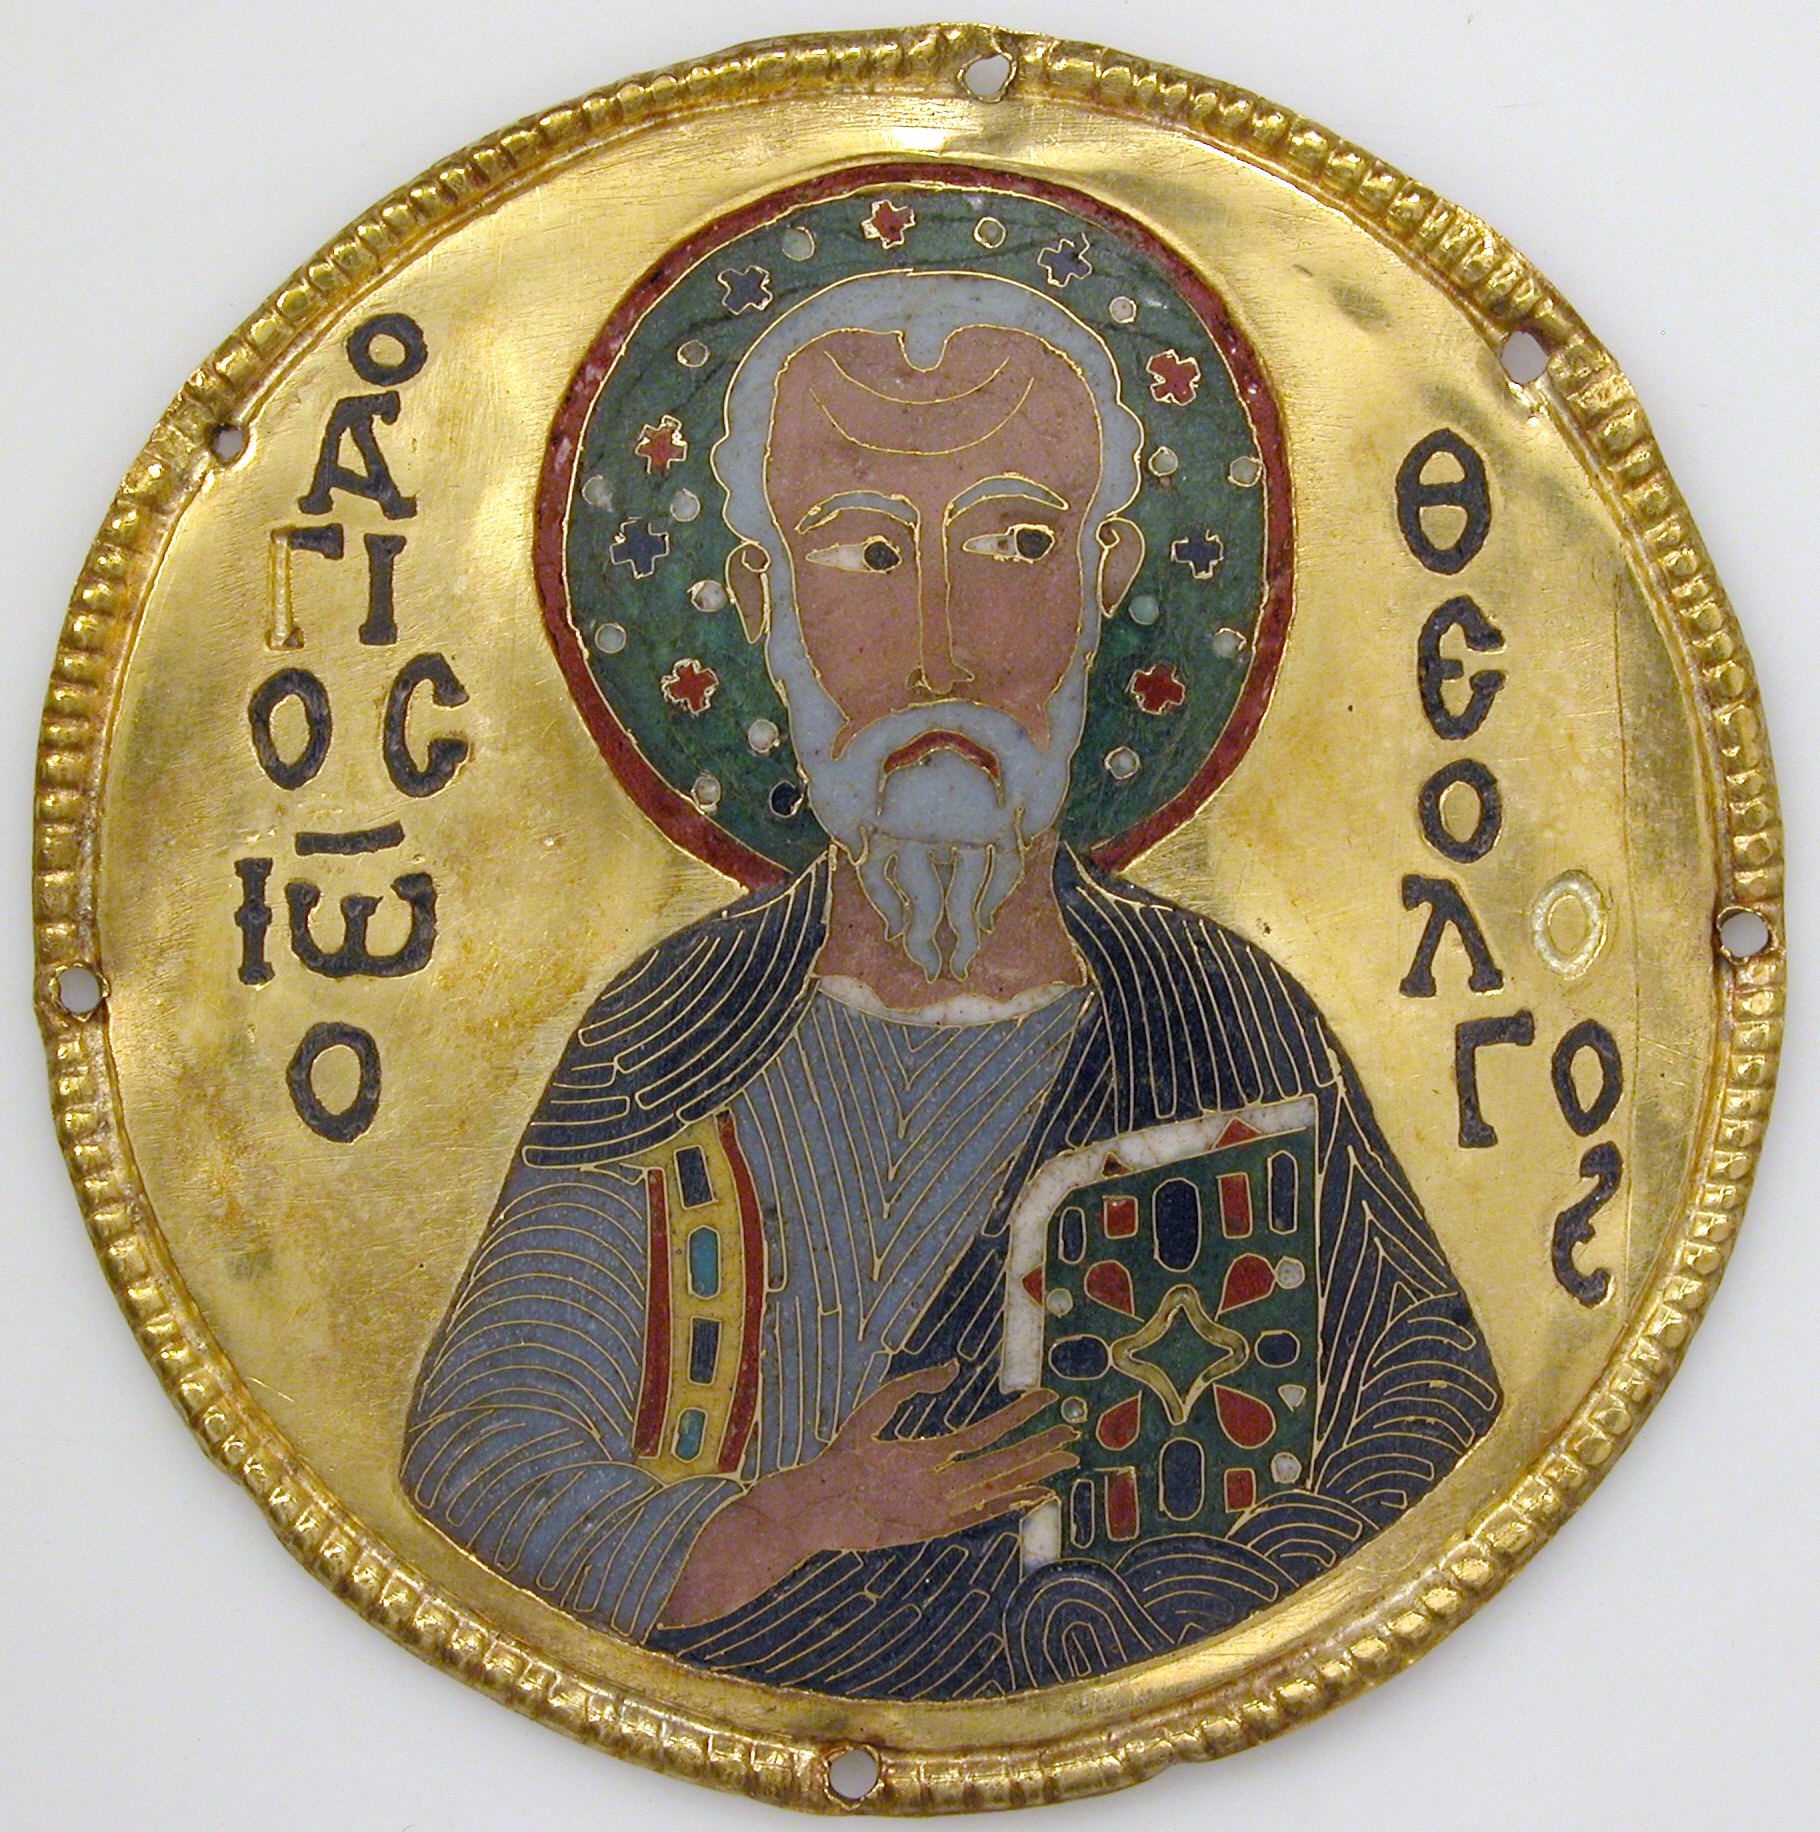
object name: medallion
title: Medallion with Saint John the Evangelist from an Icon Frame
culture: byzantine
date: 1100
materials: enamel, gold, silver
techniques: enamel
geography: constantinople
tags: saint john the evangelist